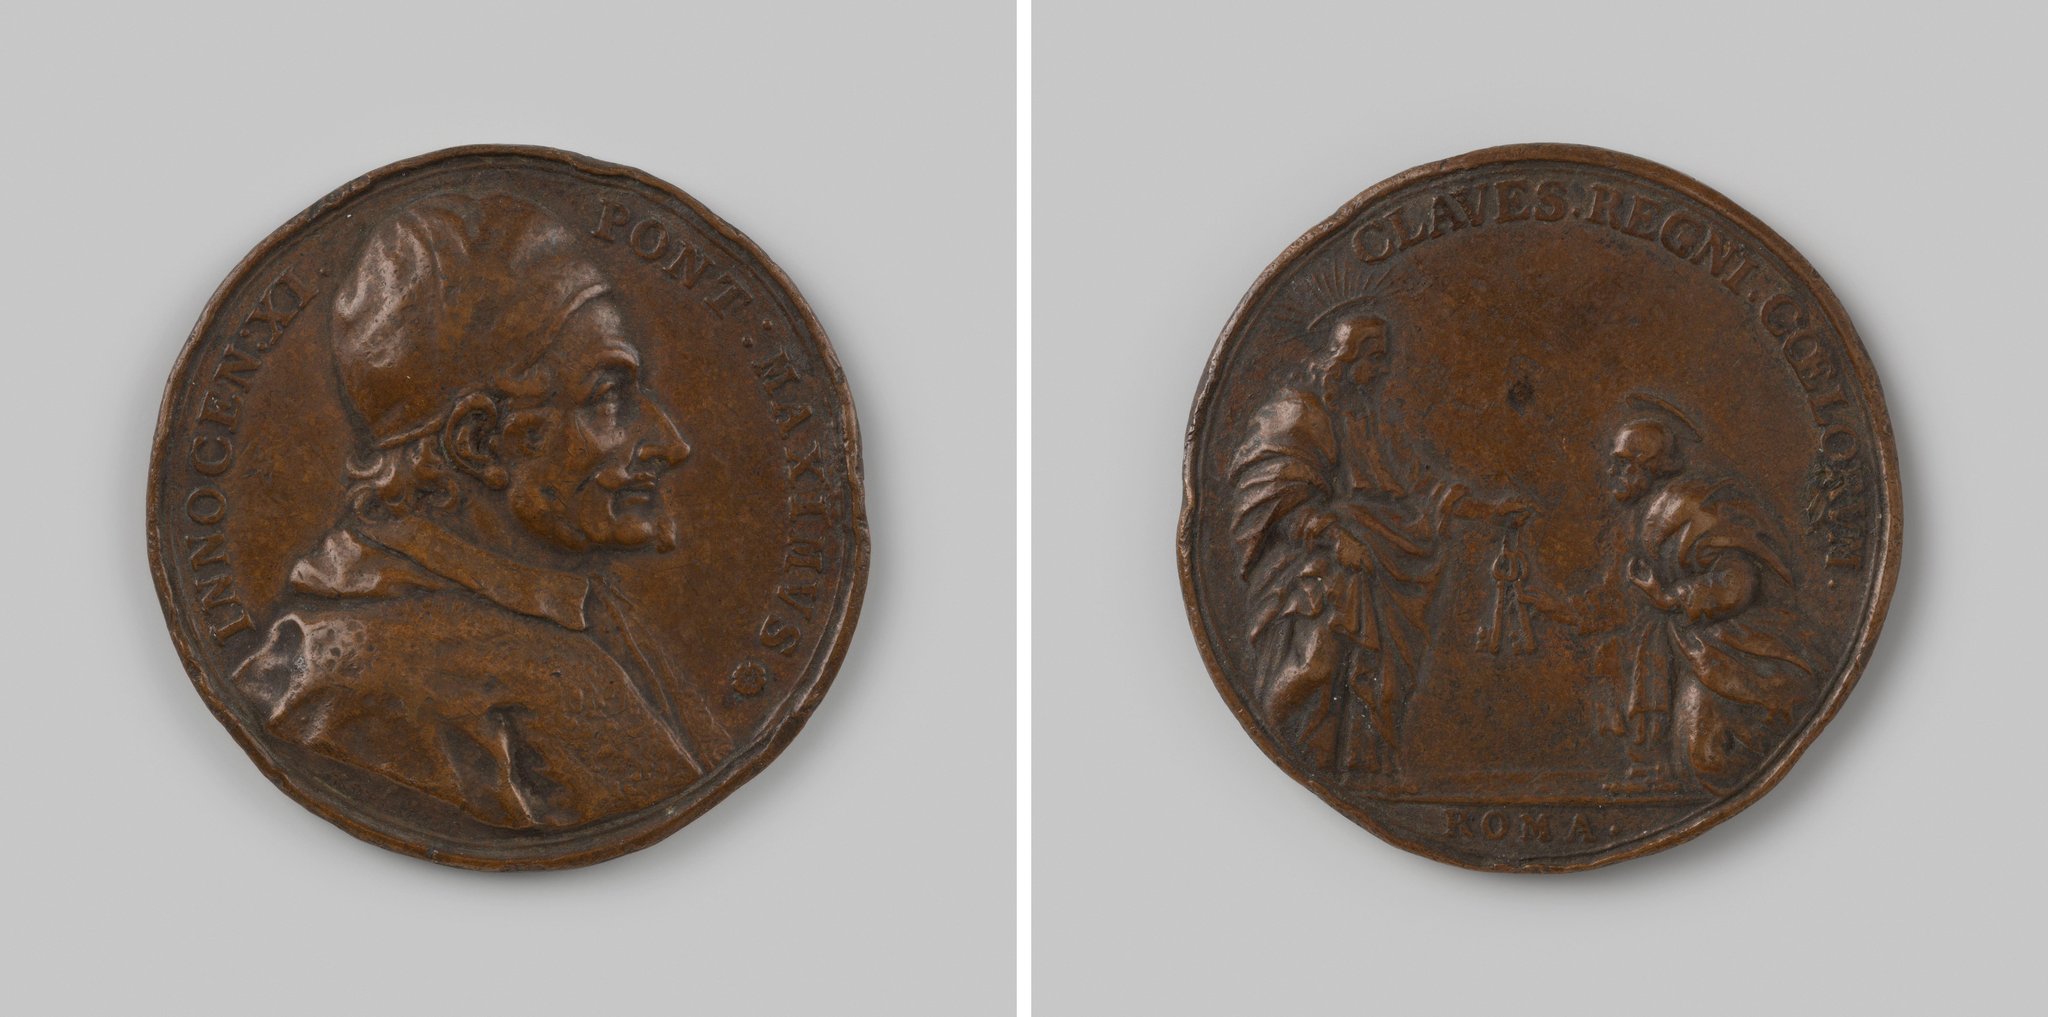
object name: history medal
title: Aantreden van Paus Innocentius XI 1676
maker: arvid karlsteen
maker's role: medailleur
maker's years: 1647-1718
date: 1676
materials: copper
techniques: striking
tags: christ gives the keys of heaven to peter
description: Koperen penning, op de voorzijde het borstbeeld van Innocentius naar rechts met omschrift, op de keerzijde Christus die de knielende Petrus de sleutels van de hemel overhandigt, met omschrift en afsnedetekst.